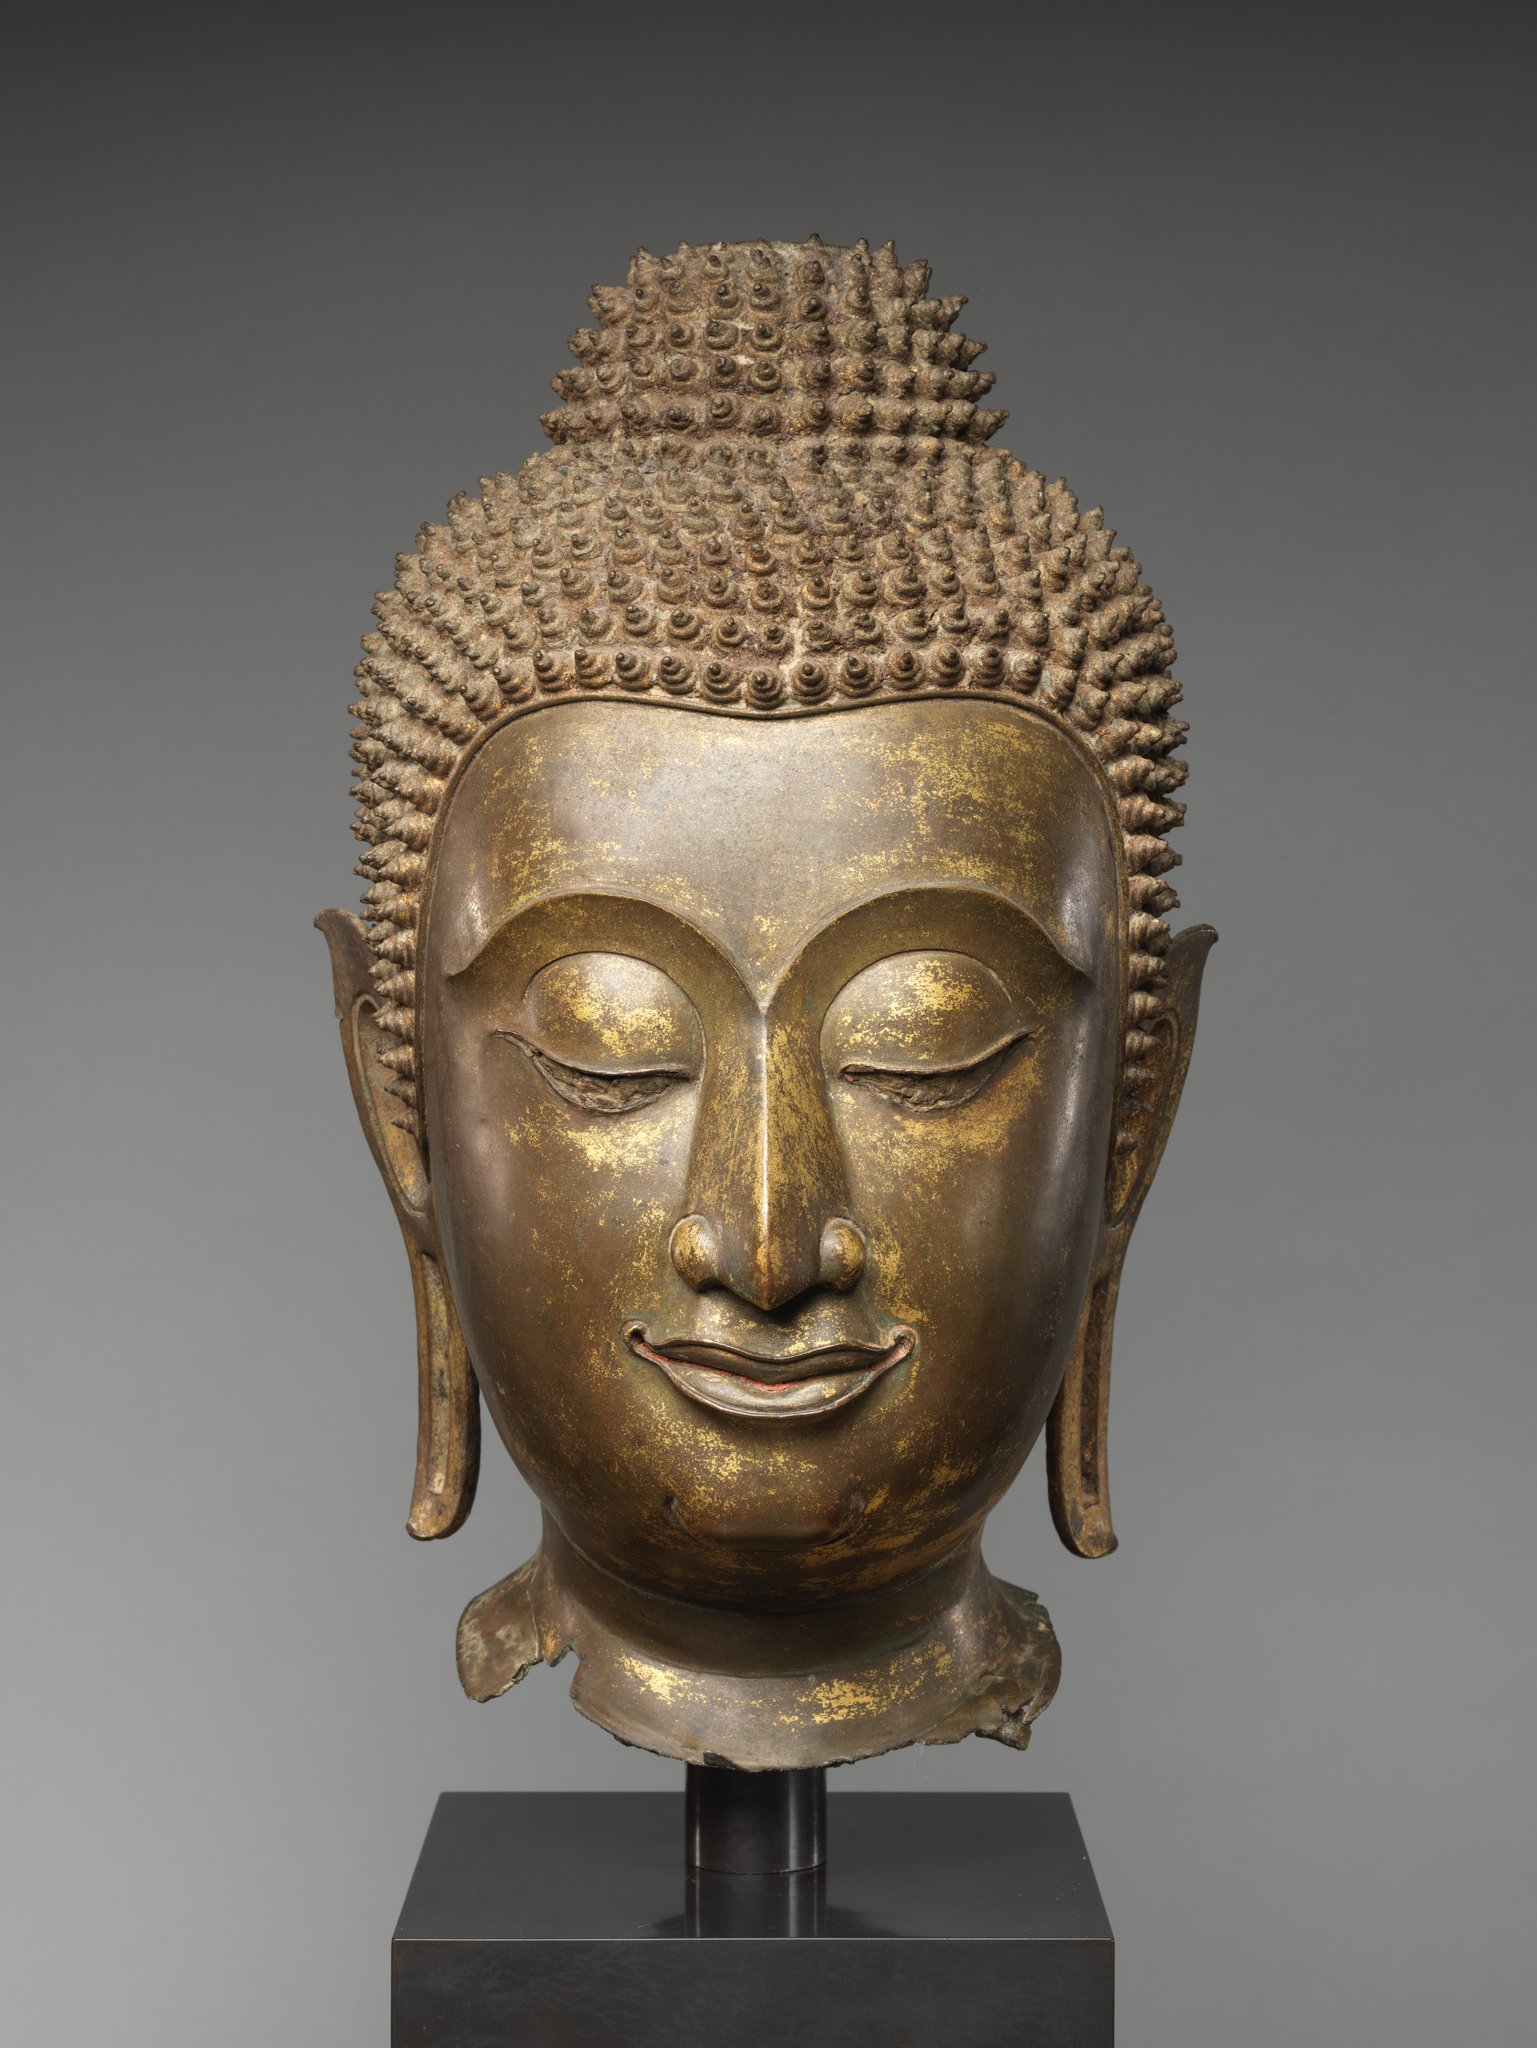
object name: head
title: Head of Buddha Shakyamuni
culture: thai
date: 1401-1600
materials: bronze, gilt